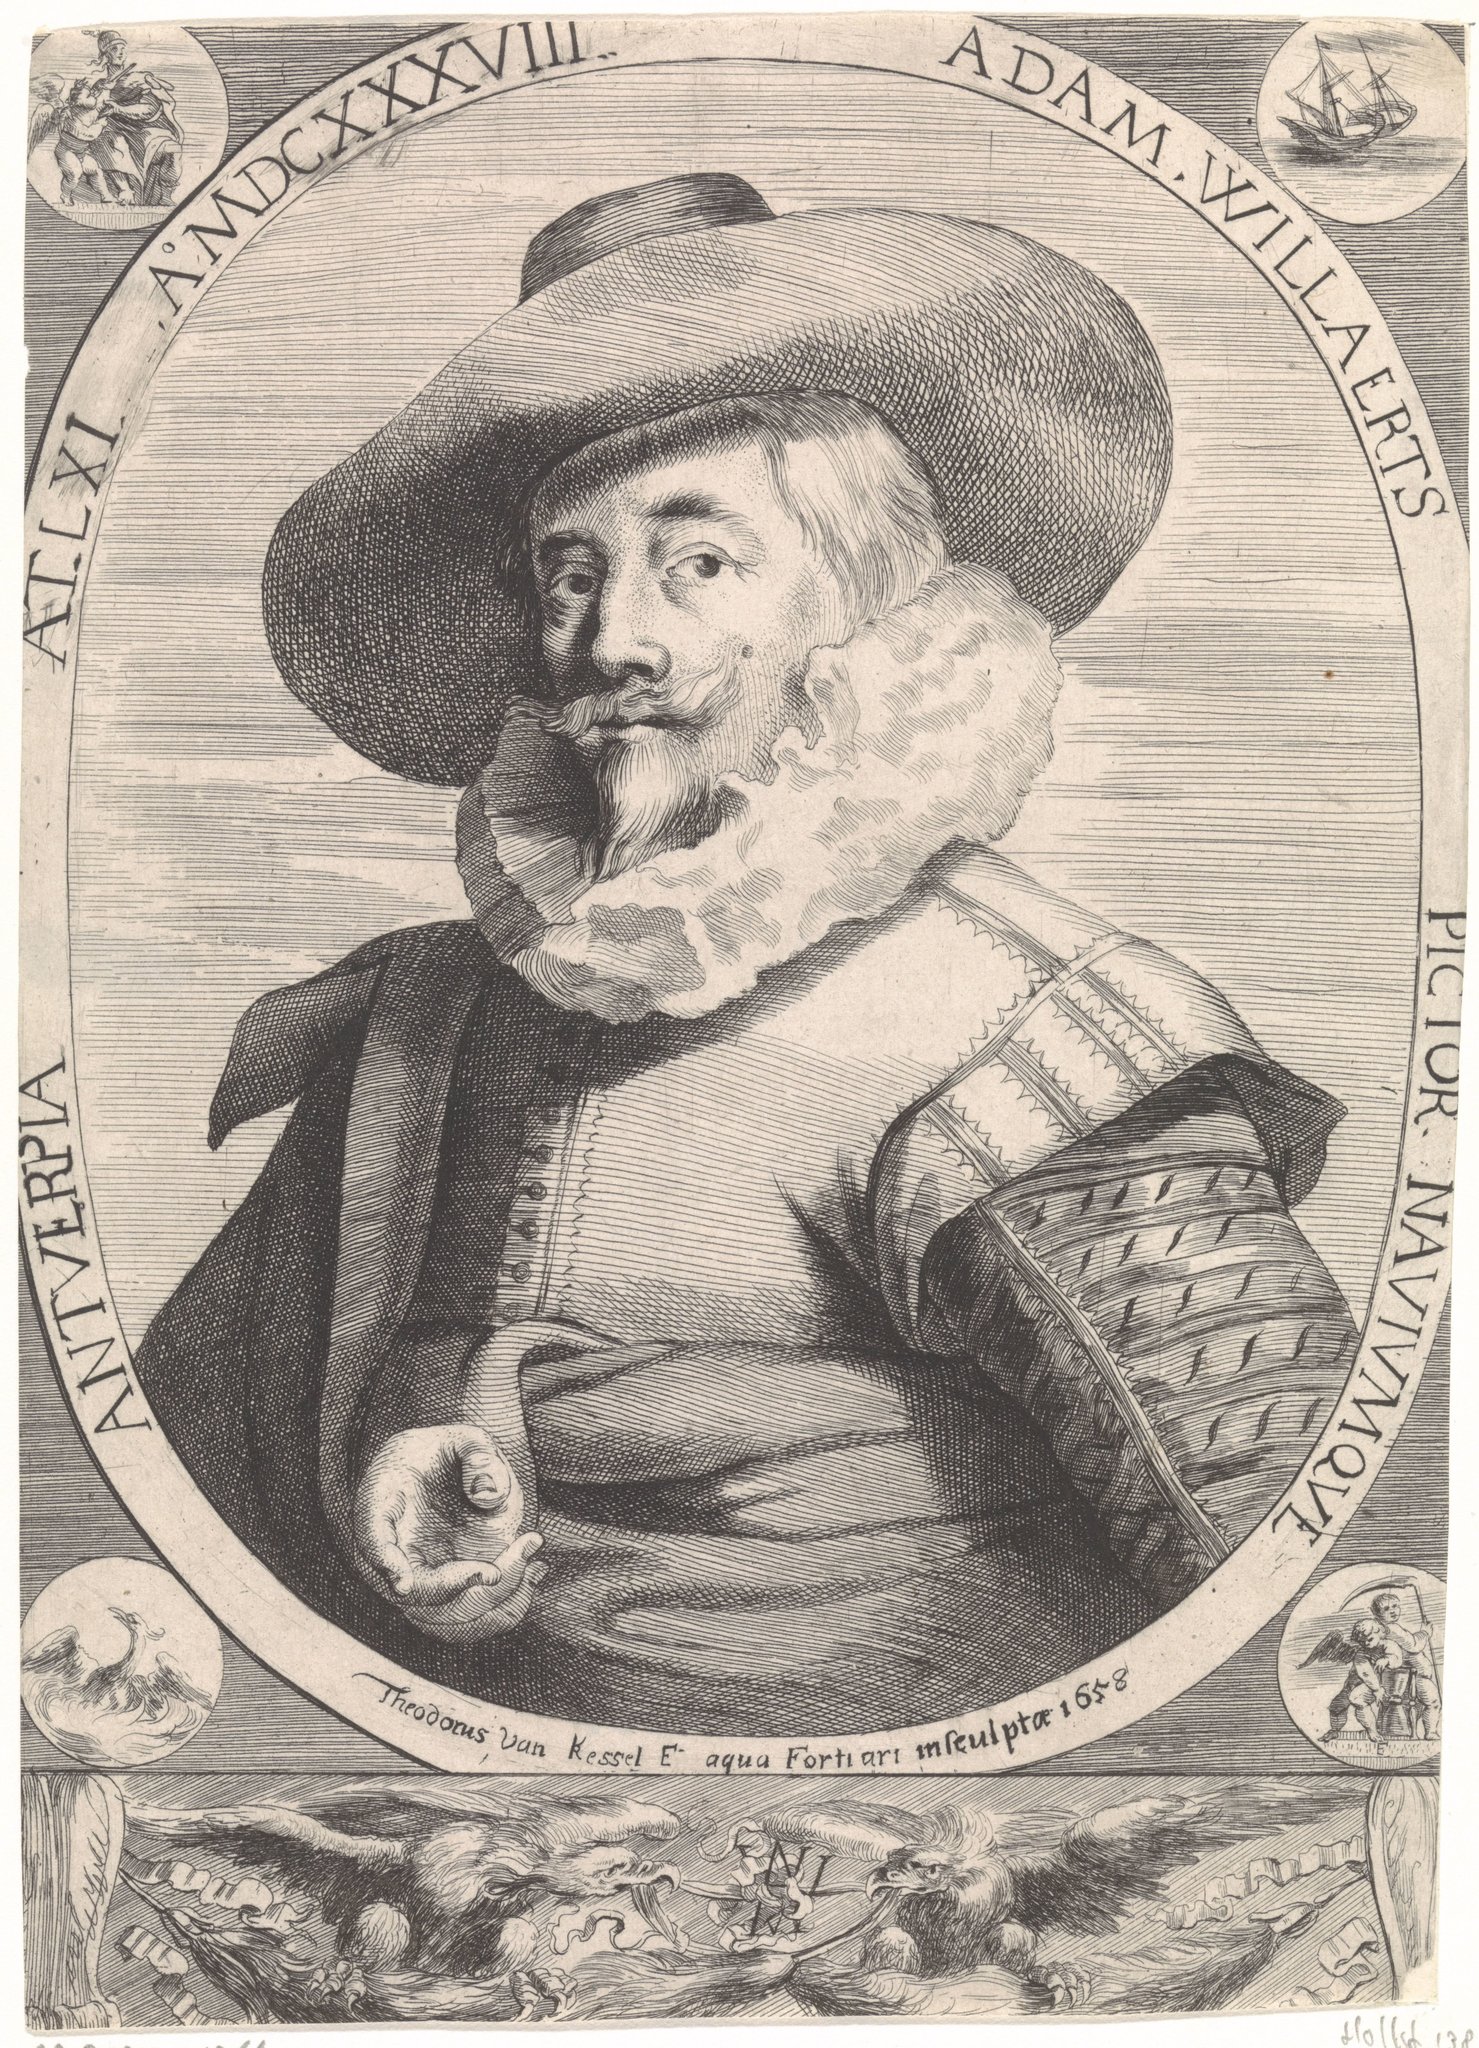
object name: print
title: Portret van Adam Willaerts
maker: theodorus van kessel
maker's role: print maker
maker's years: 1620-1660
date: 1658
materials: paper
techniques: engraving, etching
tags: london, utrecht, painter, adam willaerts, sailing-ship, sailing-boat, predatory birds, hourglass, portrait, self-portrait of artist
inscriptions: collector's mark: Lugt 2228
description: Portret ten halven lijve in een ovaal naar links van de zeeschilder Adam Willaerts. In de vier hoeken van het blad staan medaillons en onder het ovaal een strook met twee arenden.